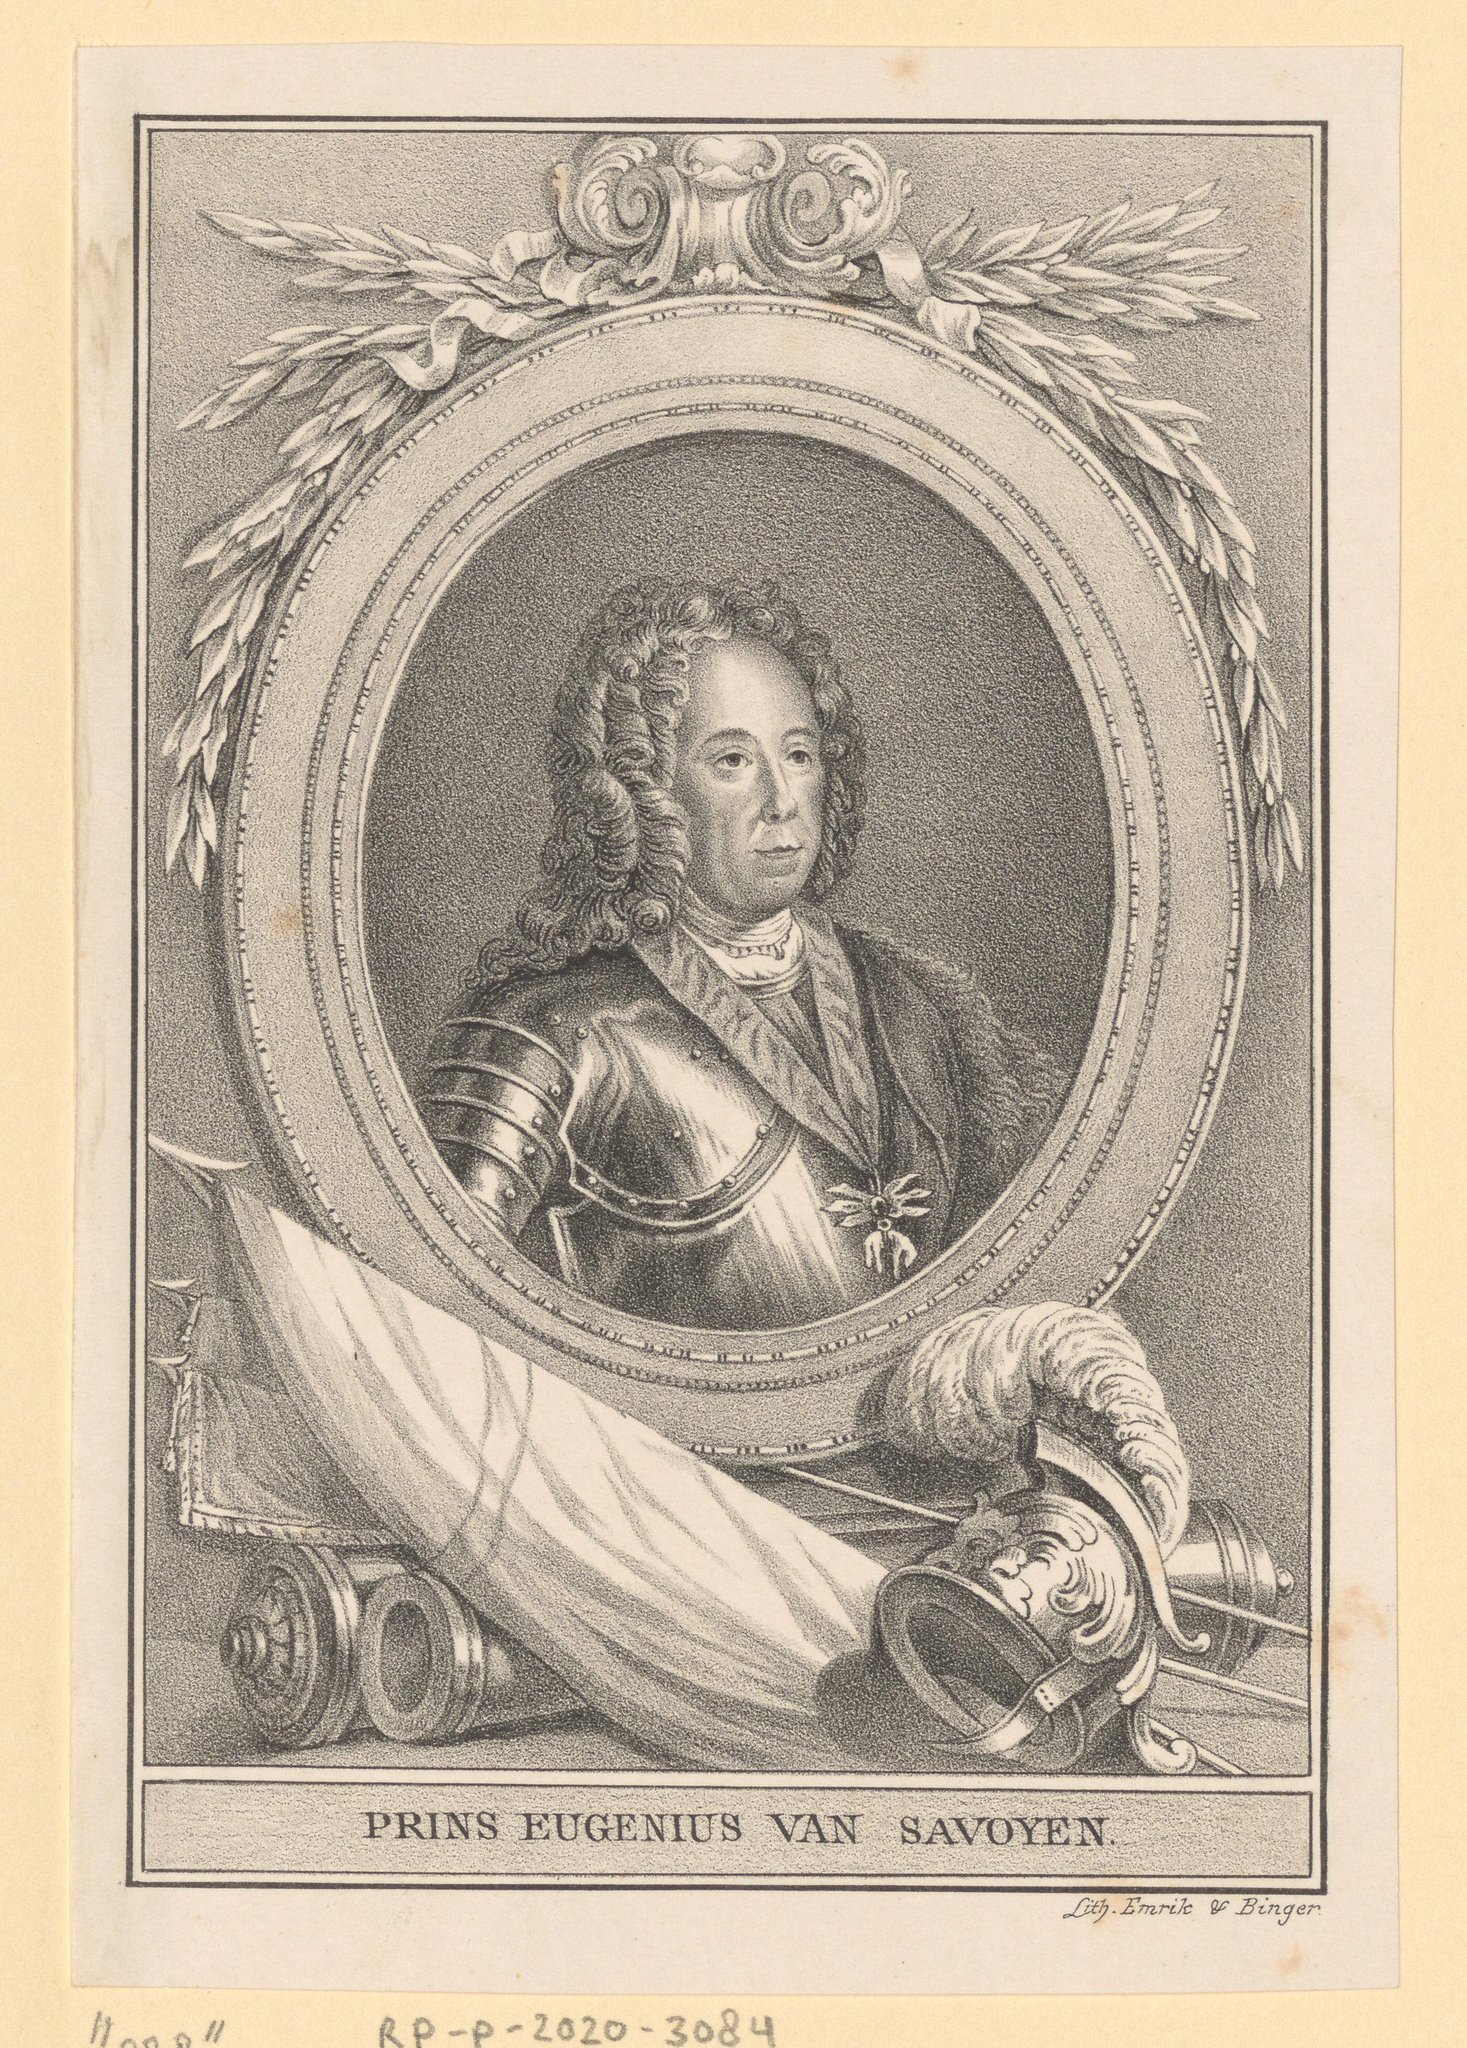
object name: print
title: Portret van Eugenius van Savoye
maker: Anonymous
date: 1857-1900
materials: paper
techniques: lithograph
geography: haarlem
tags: paris, vienna, eugenius van savoye, helmet, historical persons, knighthood order of the golden fleece